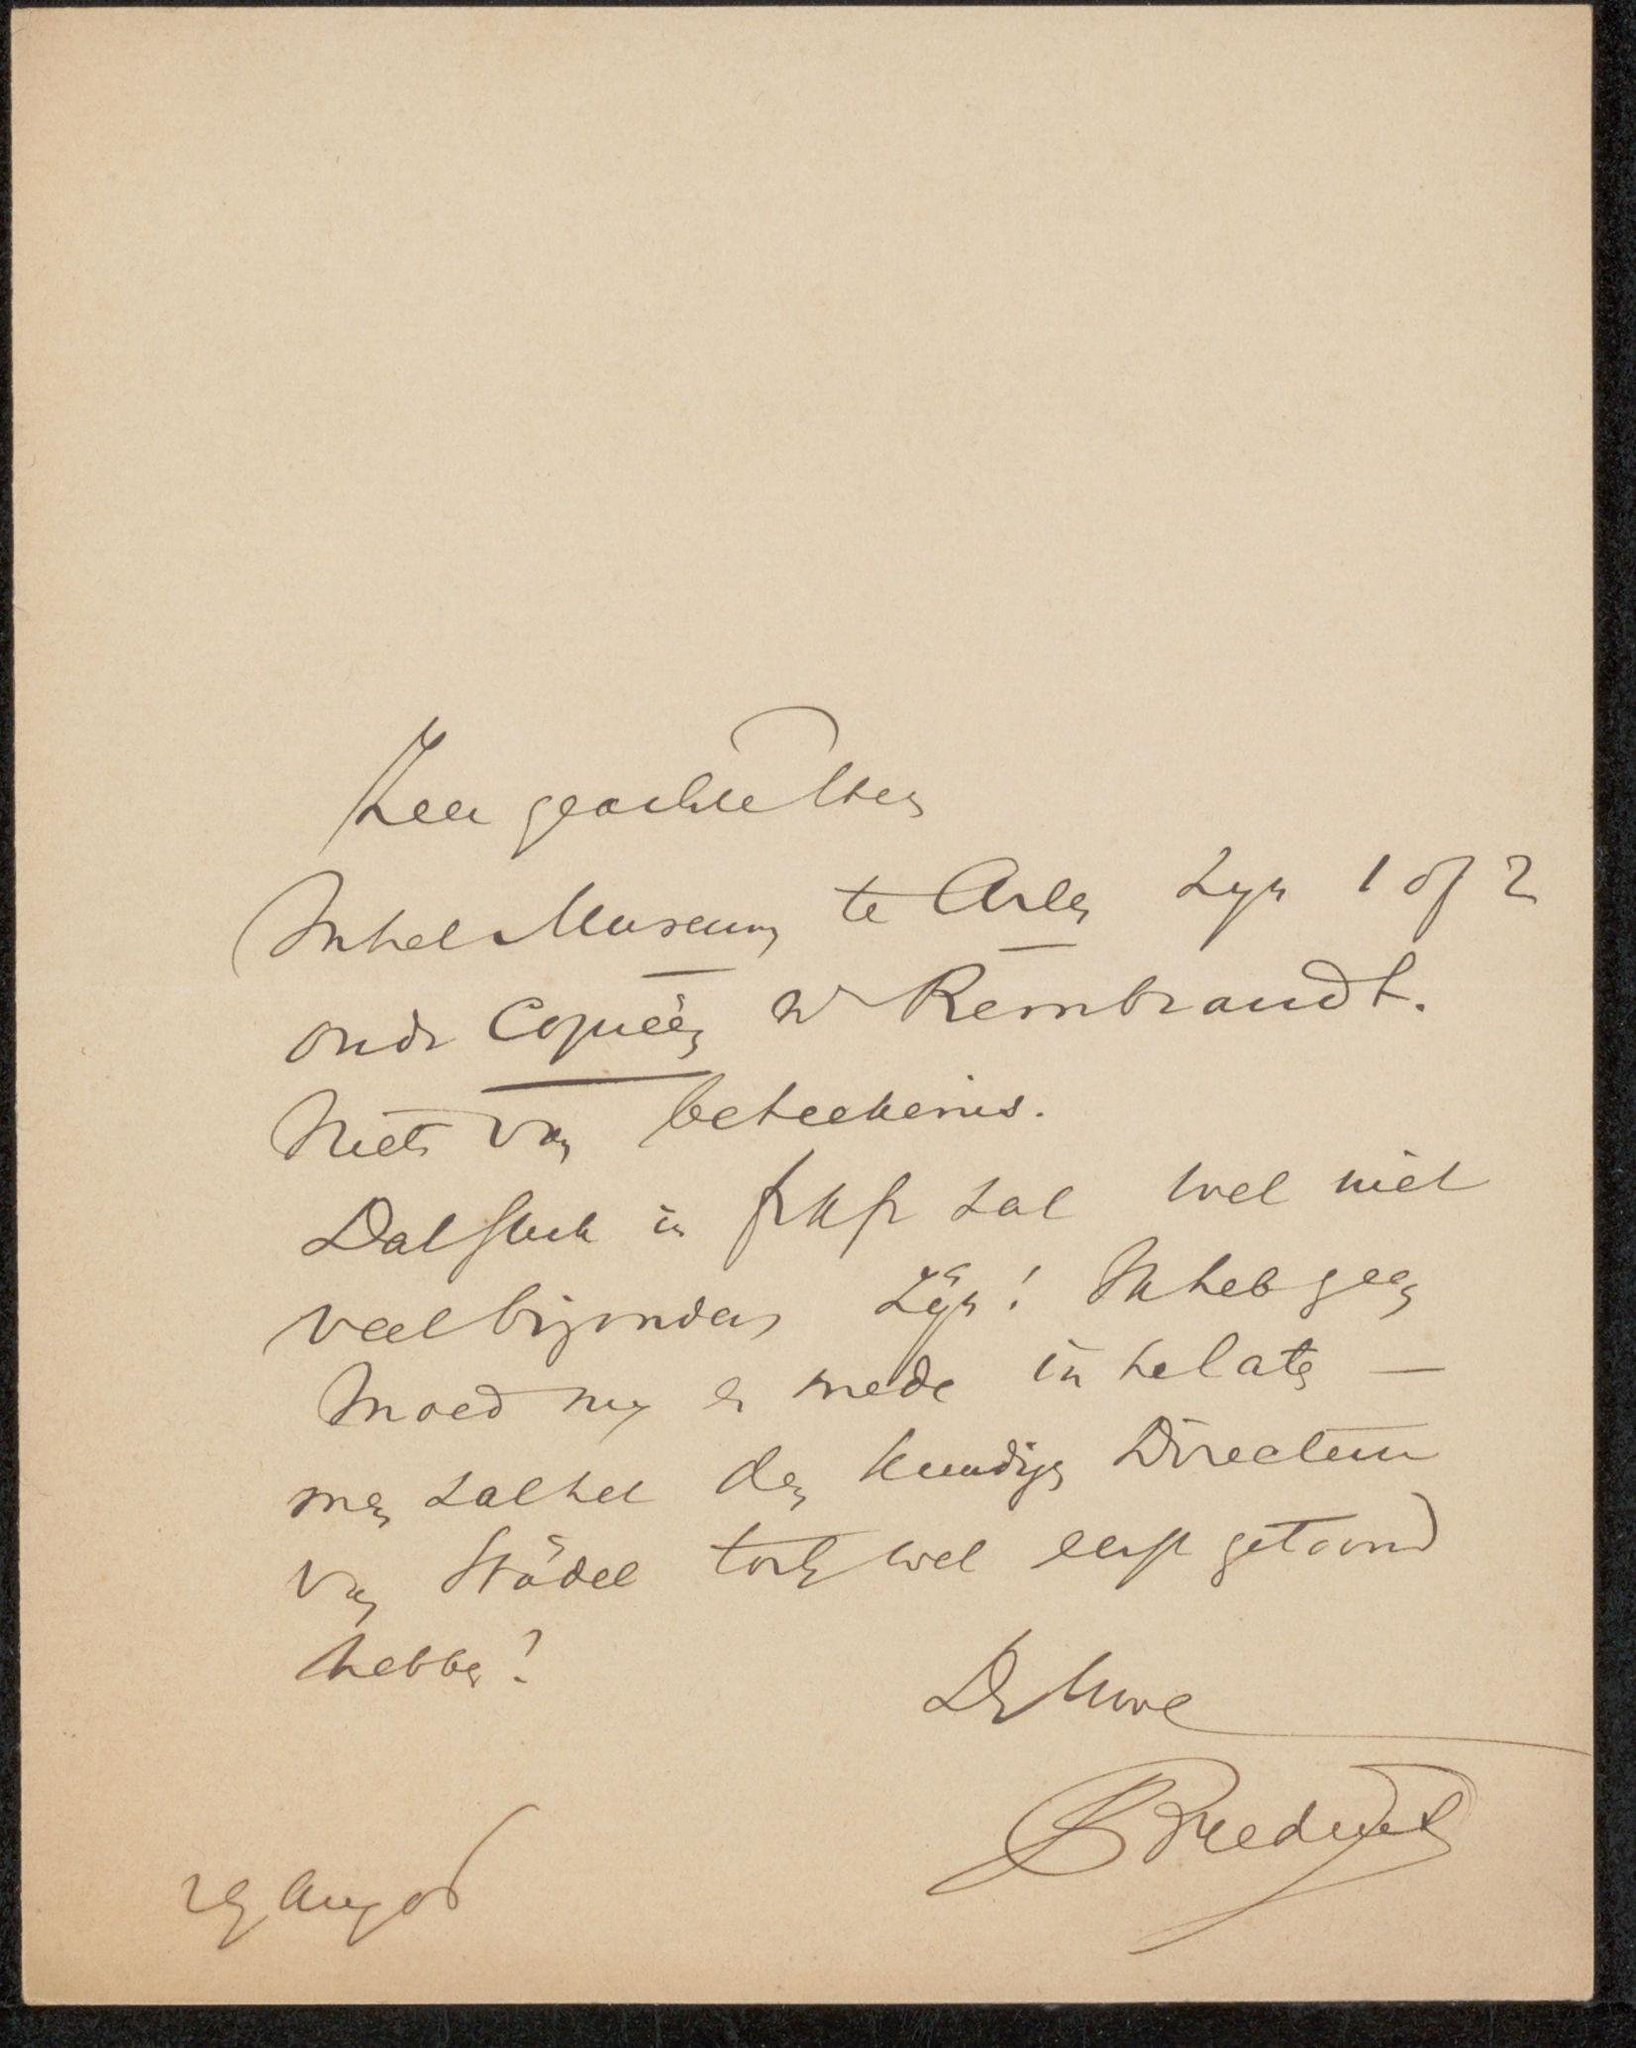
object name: letter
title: Brief aan Philip Zilcken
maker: abraham bredius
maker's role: kunsthistoricus, museumdirecteur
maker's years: 1855-1946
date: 1906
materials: ink, paper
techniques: pen, writing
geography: the hague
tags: leiden, amsterdam, painter, print maker, draughtsman, rembrandt van rijn, the hague, philip zilcken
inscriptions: collector's mark: ‘RPK’